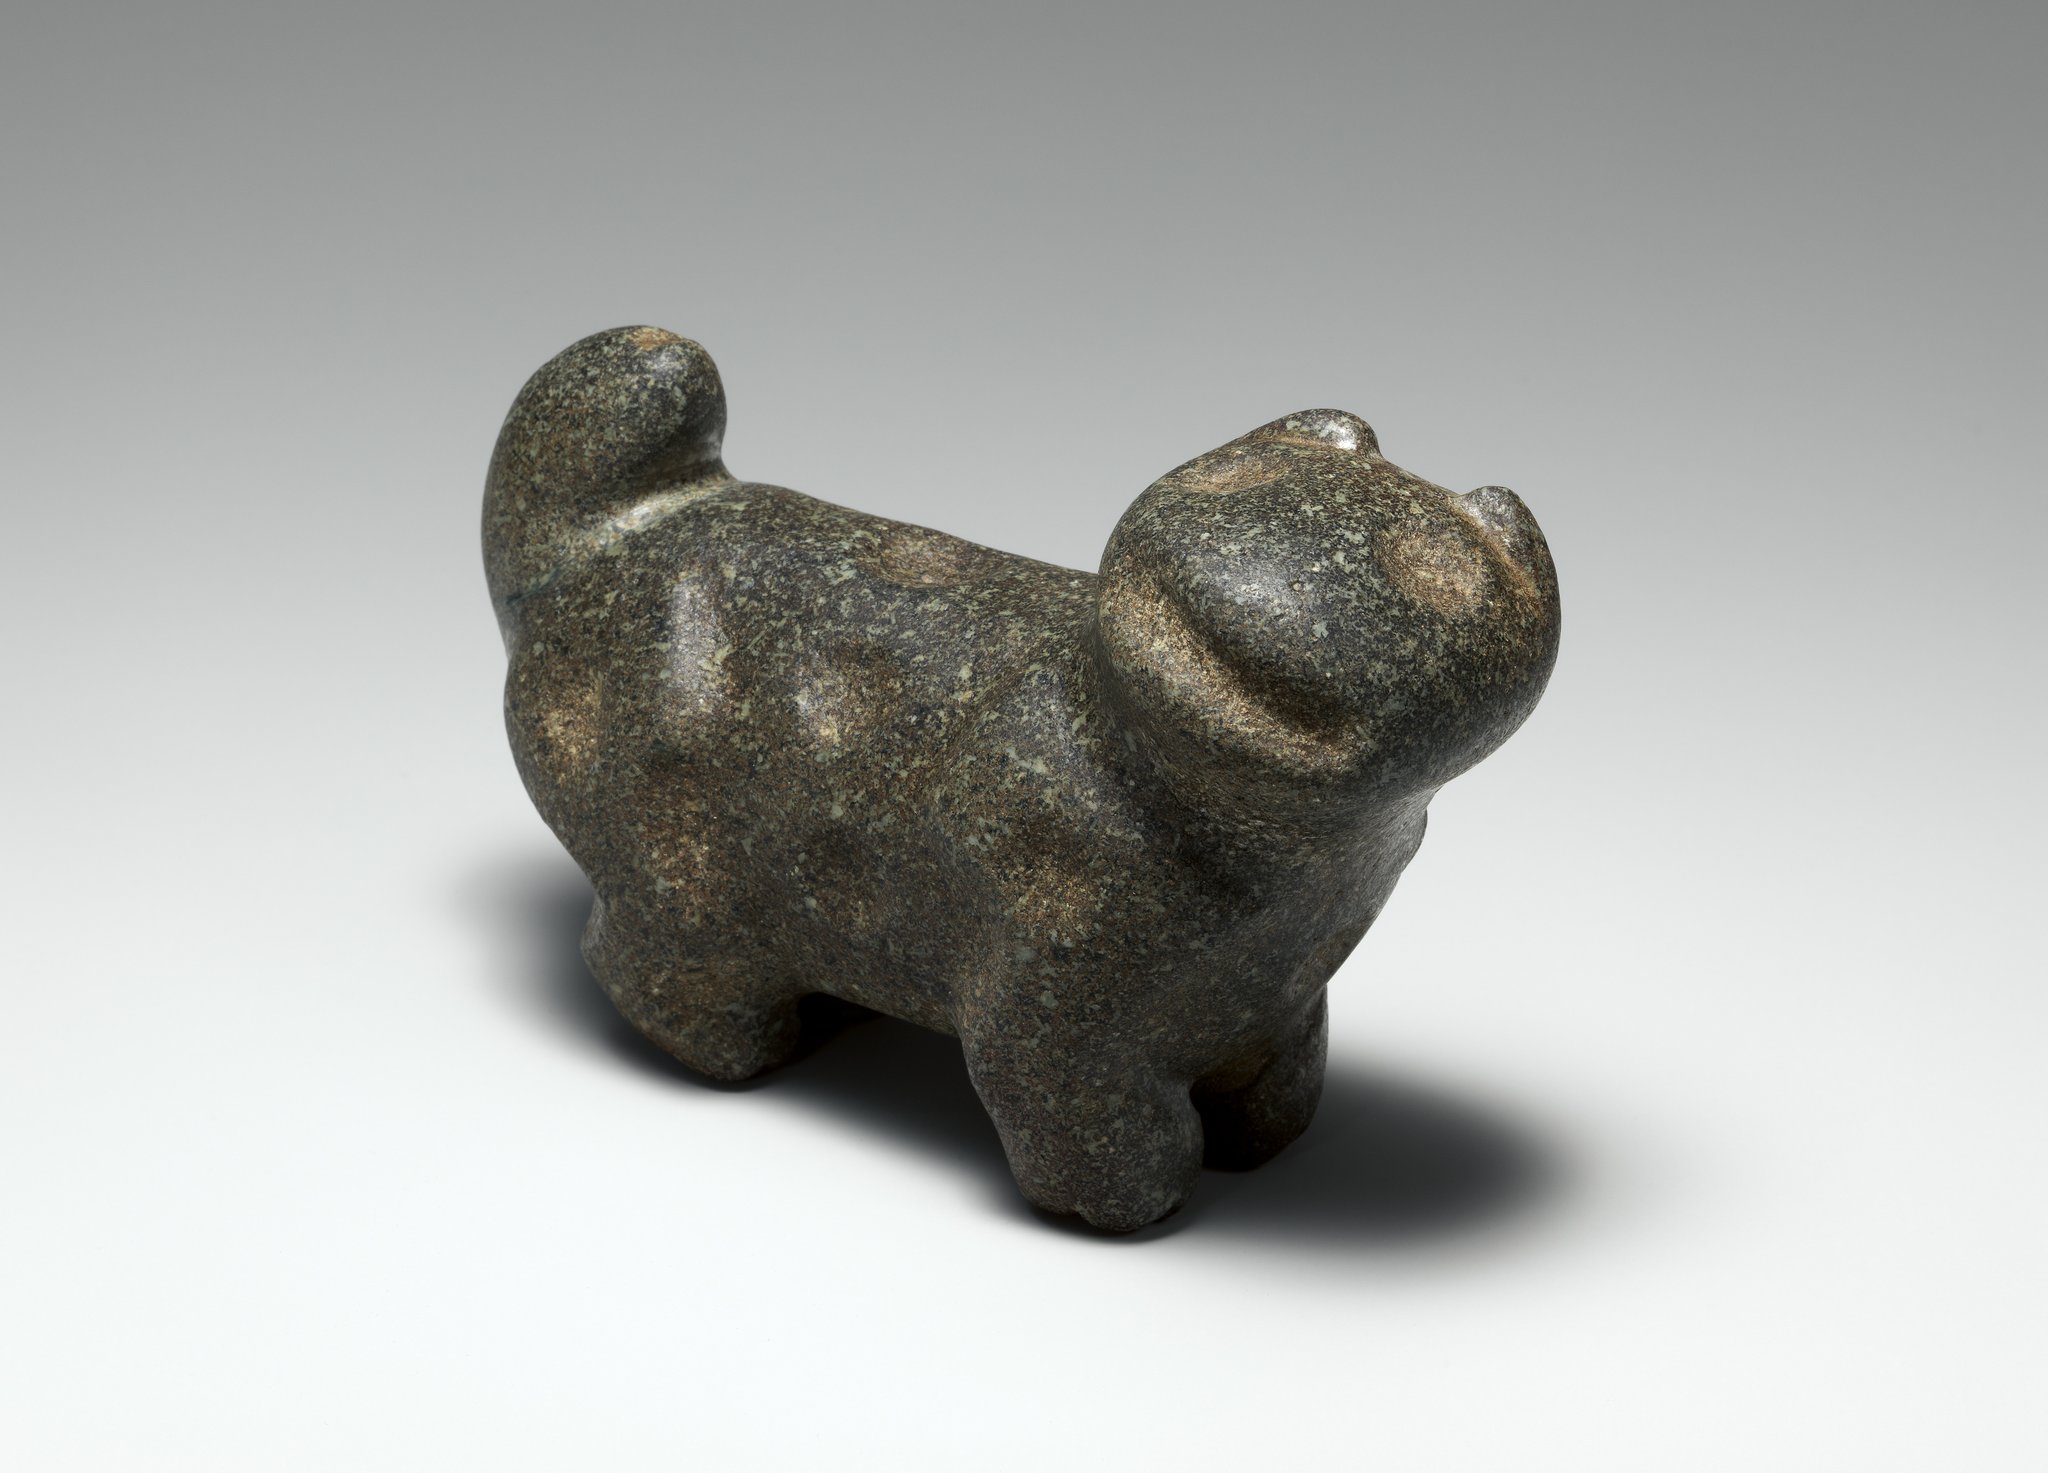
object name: sculpture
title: Feline figure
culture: condorhuasi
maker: condorhuasi artist(s)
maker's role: artist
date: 500 BCE-500 CE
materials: stone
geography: argentina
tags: cats